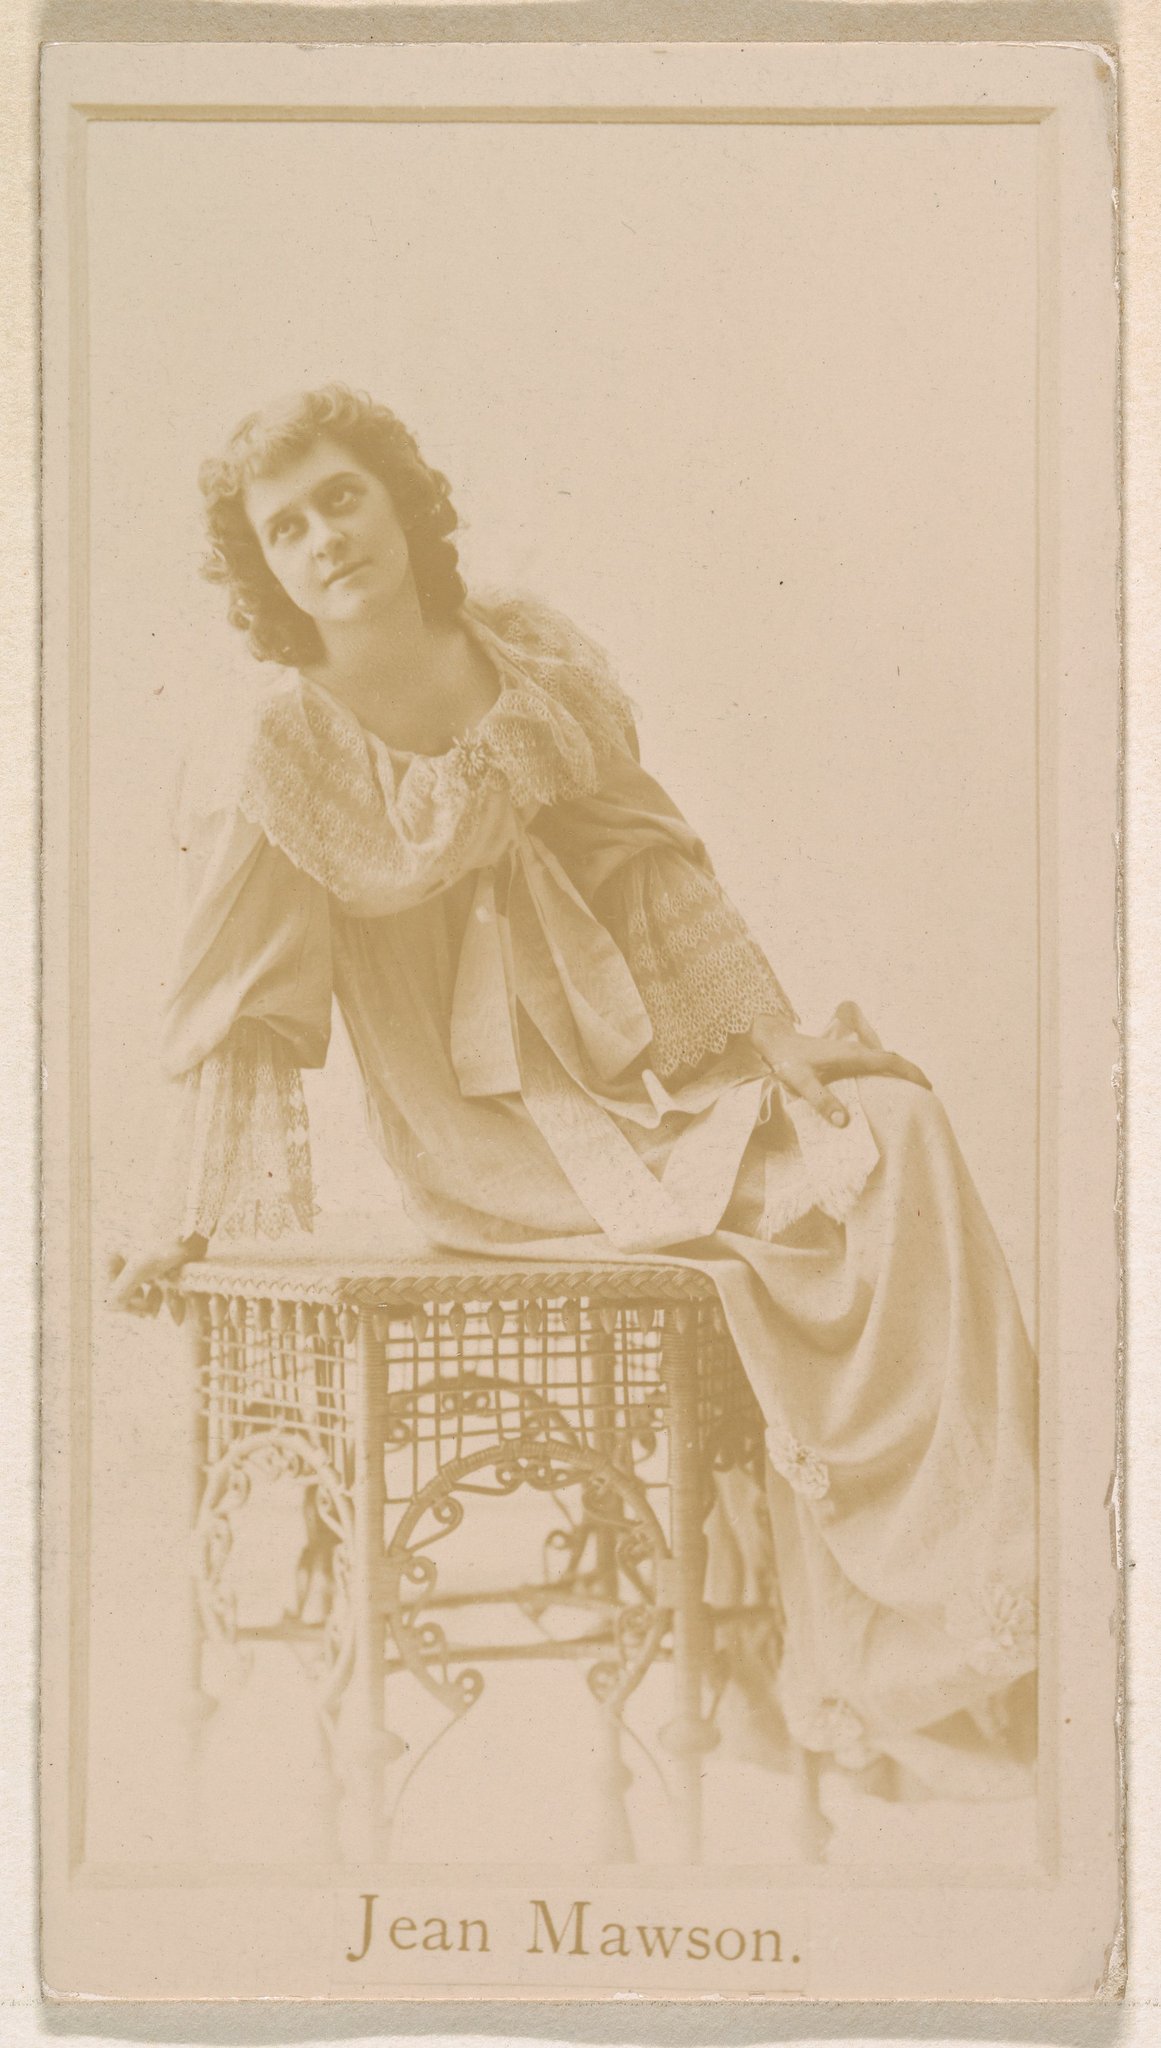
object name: photograph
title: Jean Mawson, from the Actresses series (N245) issued by Kinney Brothers to promote Sweet Caporal Cigarettes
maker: kinney brothers tobacco company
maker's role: publisher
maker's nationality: american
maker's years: 1869-2011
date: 1890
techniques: albumen silver print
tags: portraits,women,actresses